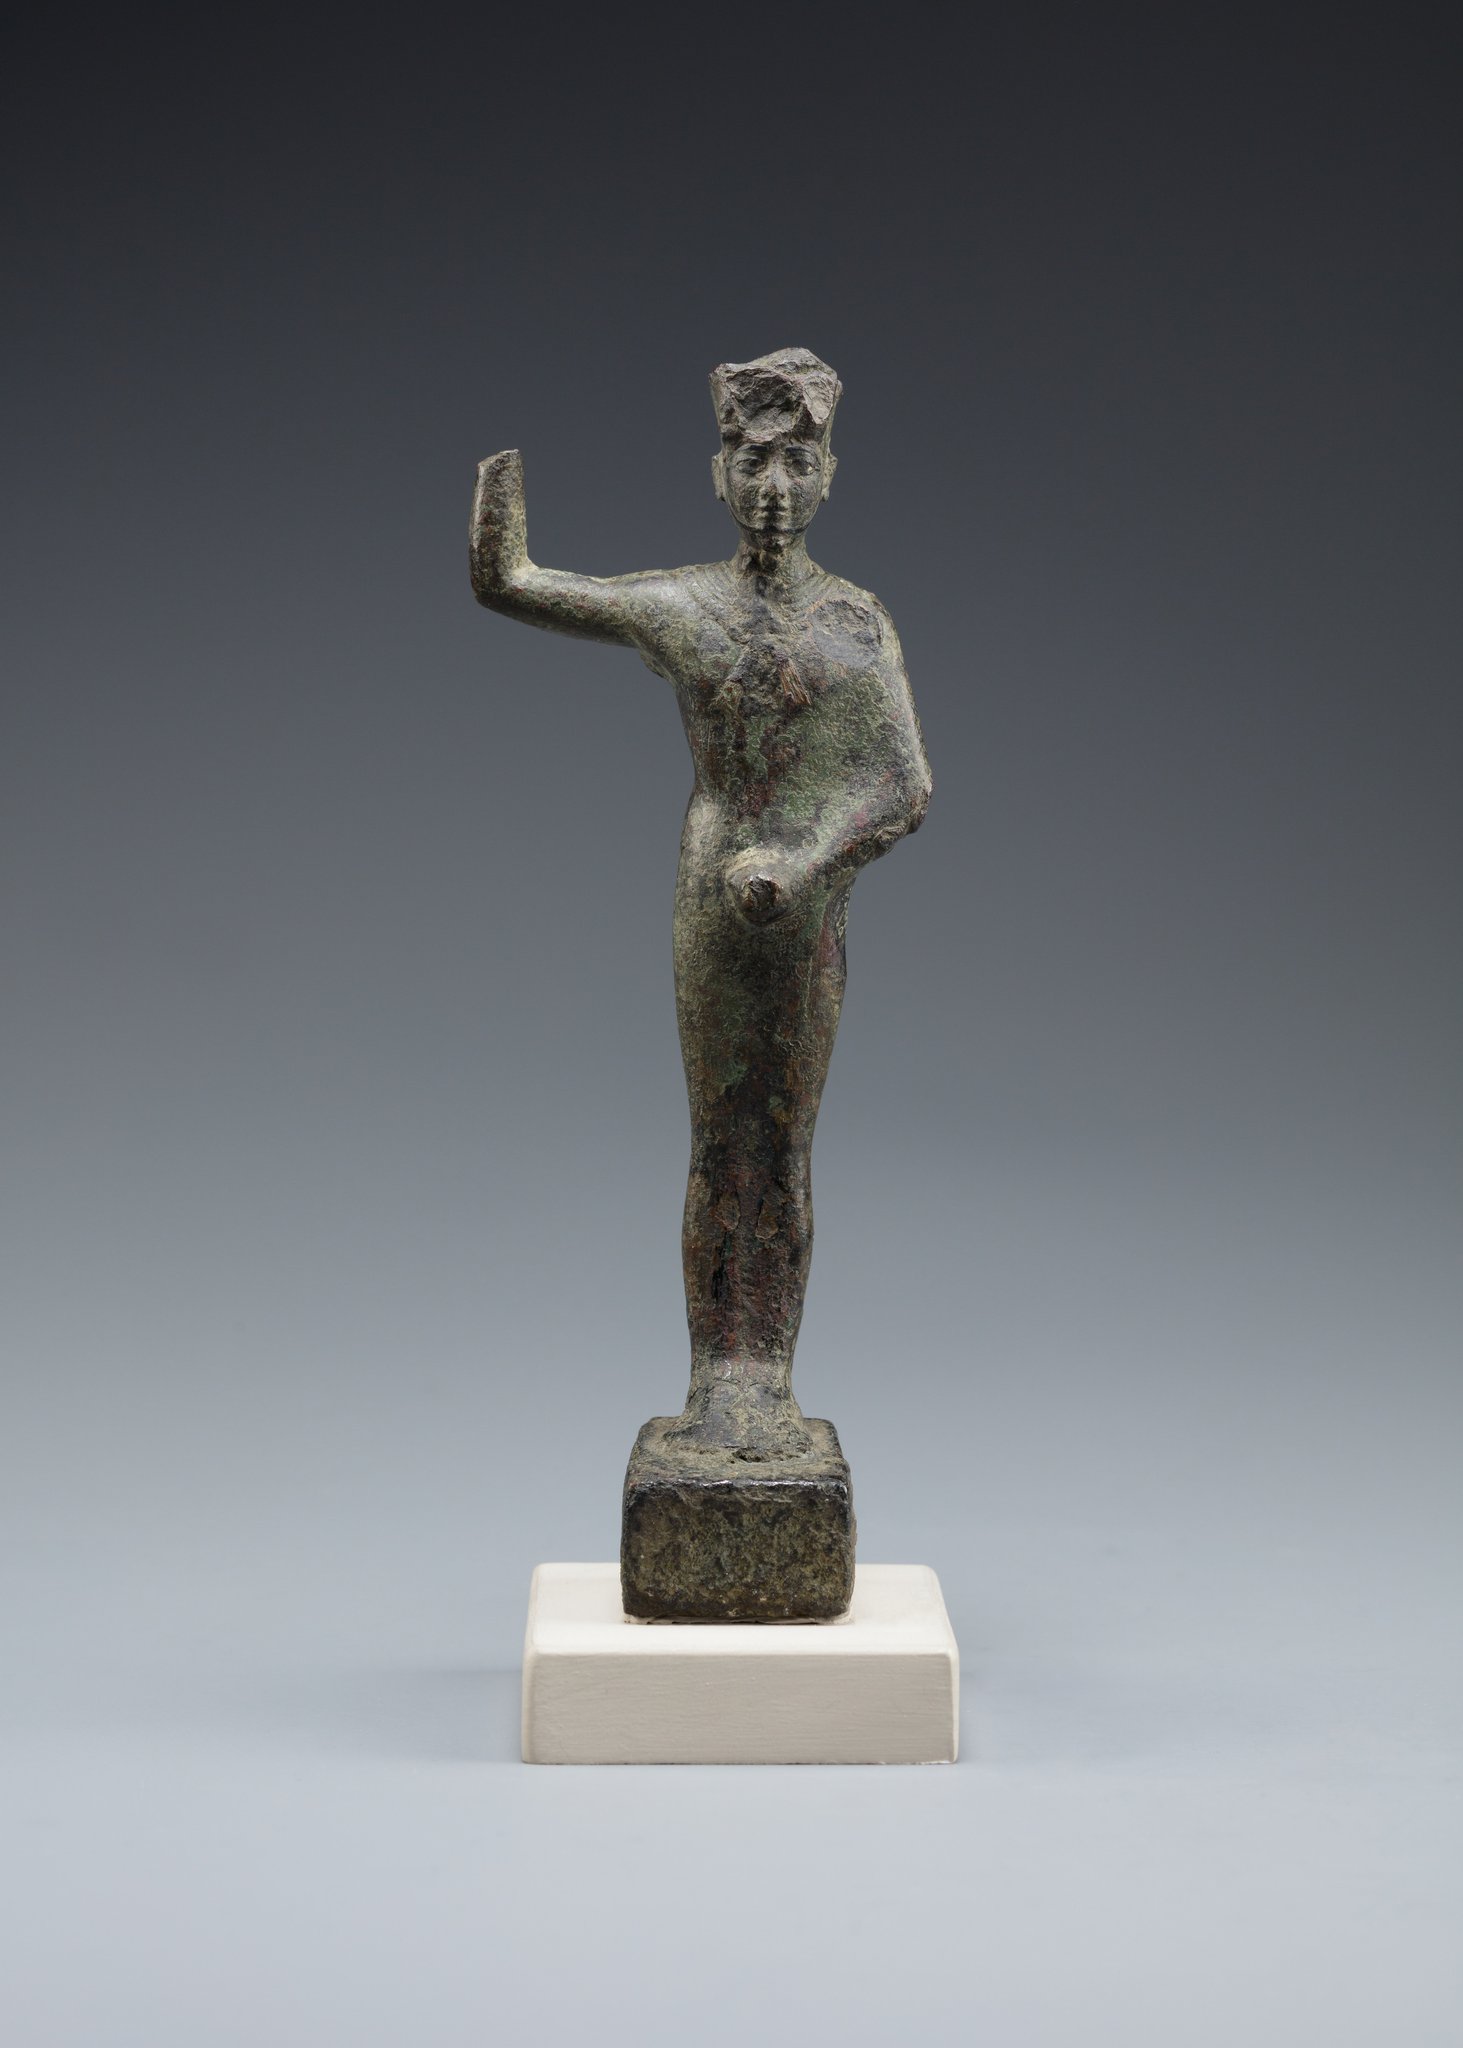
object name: statue, min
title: Min statuette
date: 1070-332 BCE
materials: metal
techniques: inlay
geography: egypt